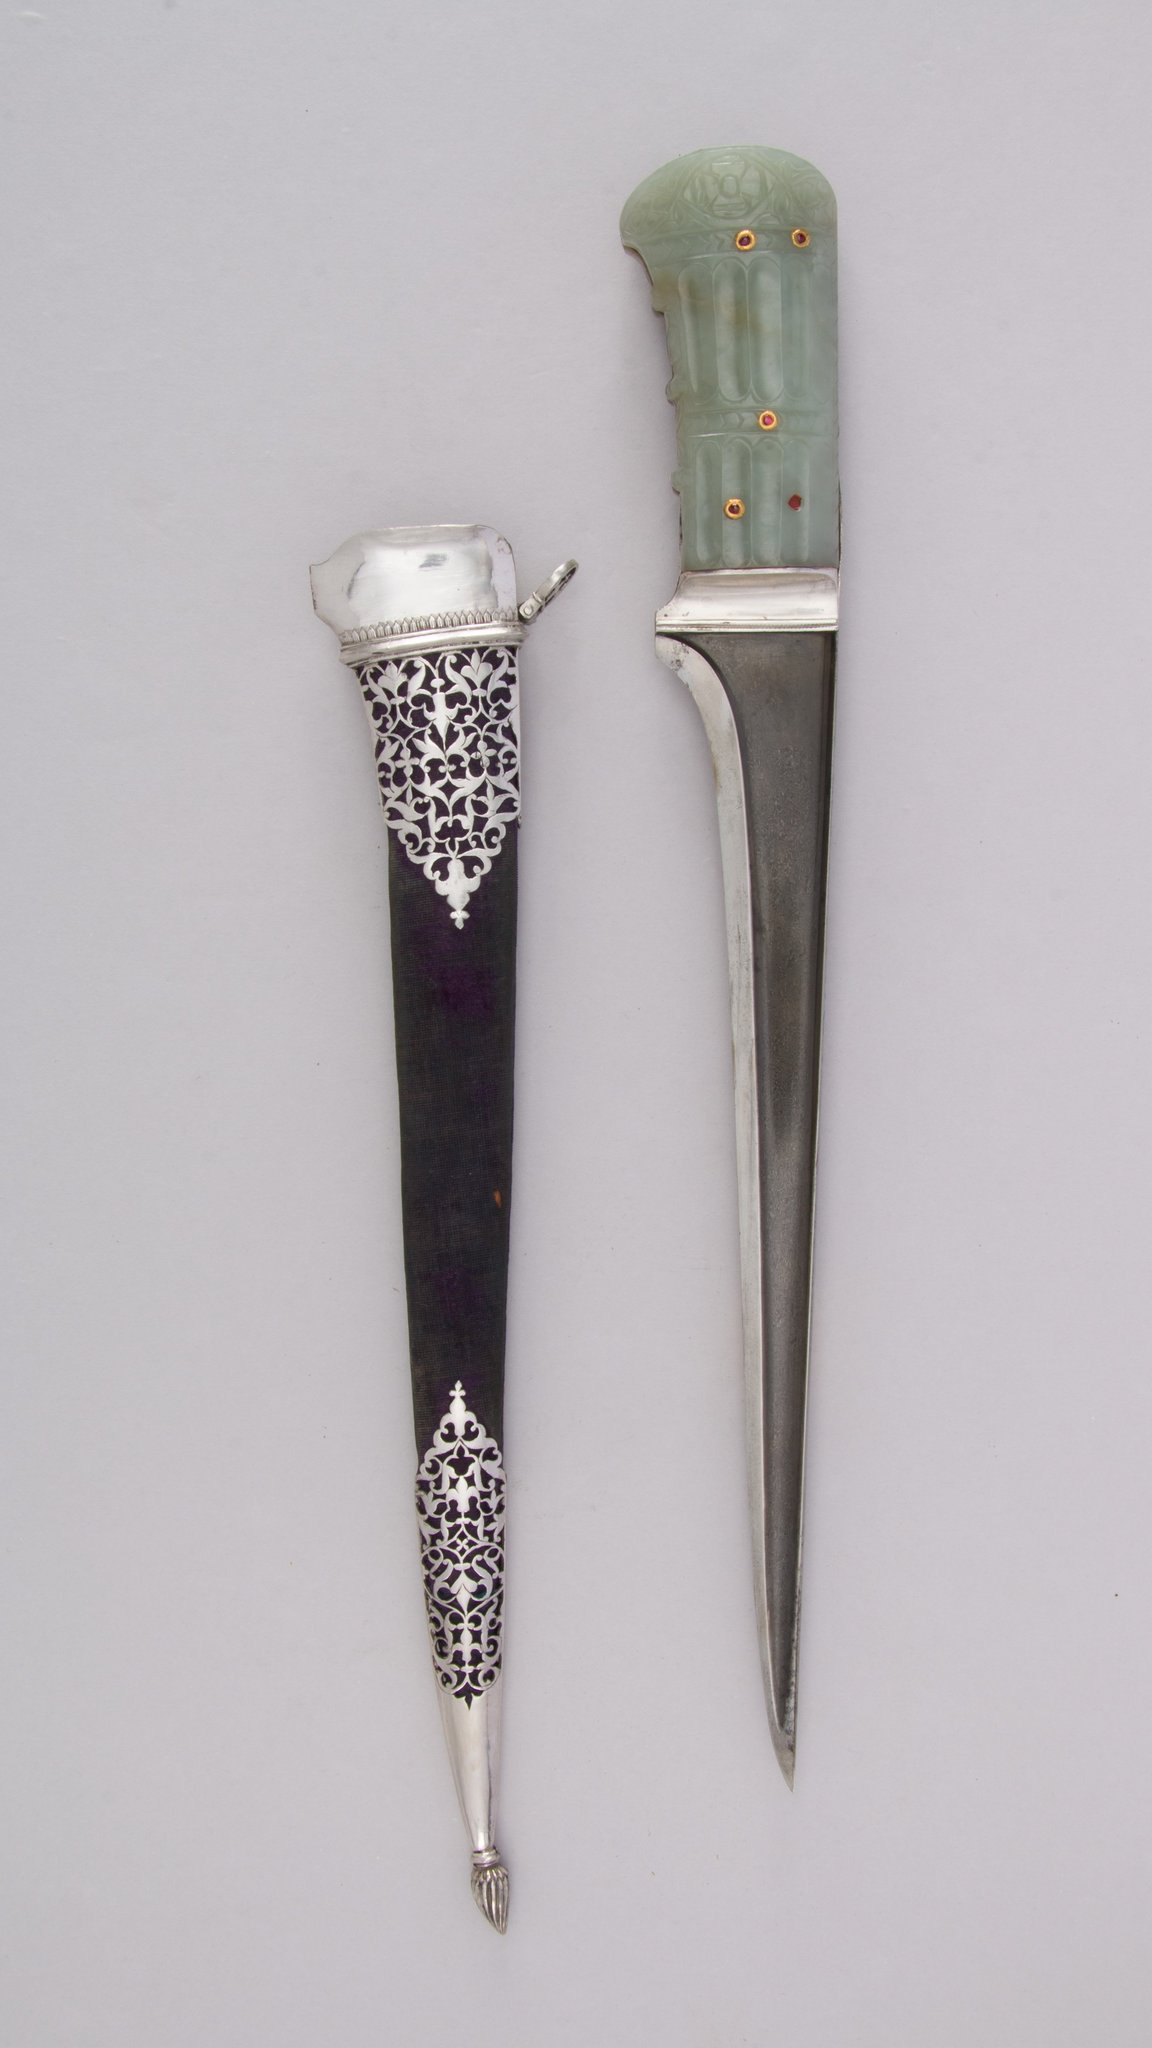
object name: dagger pesh kabz with sheath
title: Dagger (Pesh-kabz) with Sheath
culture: indian, mughal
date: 1767-1833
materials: gold, jade, gemstone, silver, steel, velvet, wood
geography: india